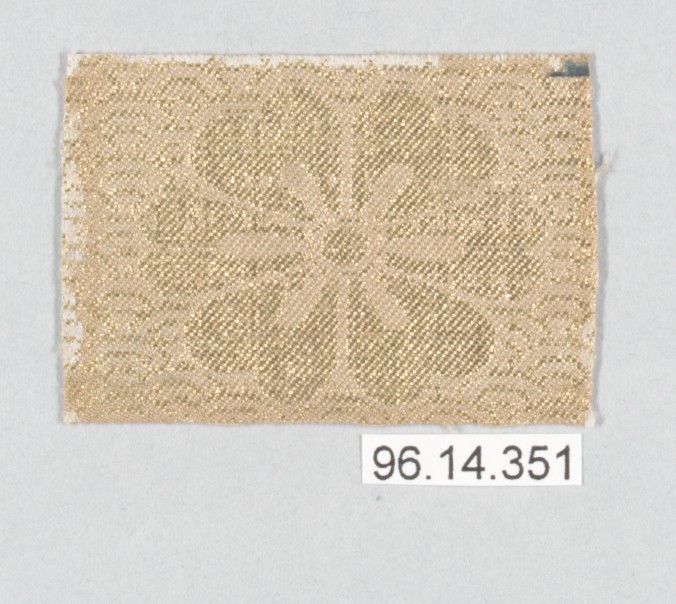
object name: piece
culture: japanese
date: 1801-1900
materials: metal thread, silk